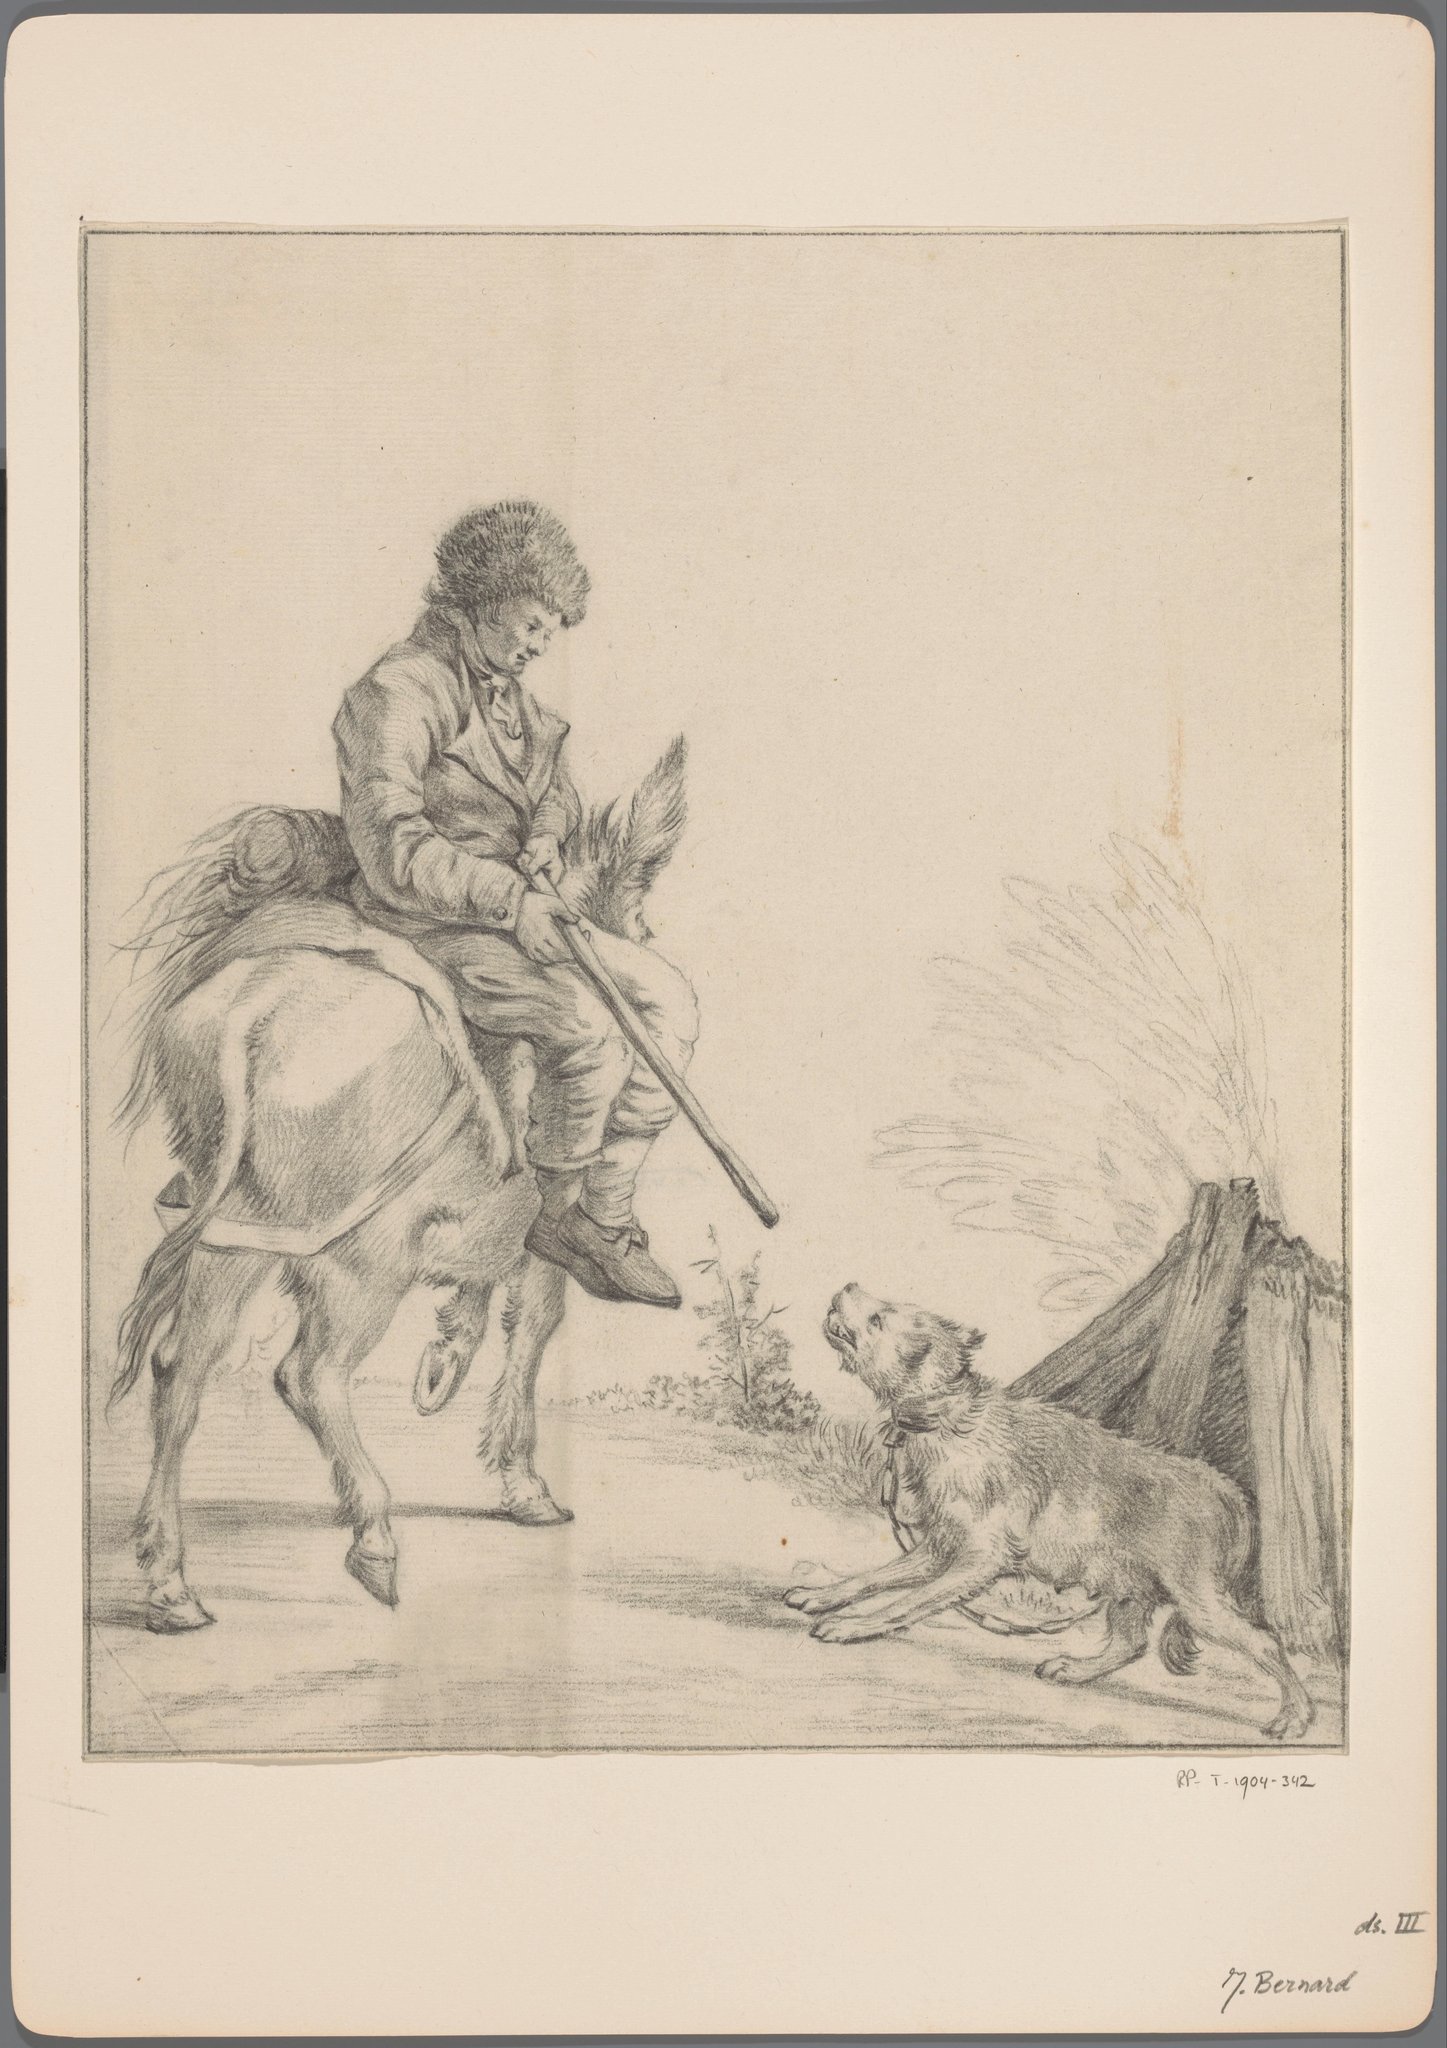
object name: drawing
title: Man op een ezel rijdt langs een blaffende hond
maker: jean bernard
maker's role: draughtsman, print maker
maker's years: 1765-1833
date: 1775-1833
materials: chalk, paper, pencil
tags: ass, donkey, dog